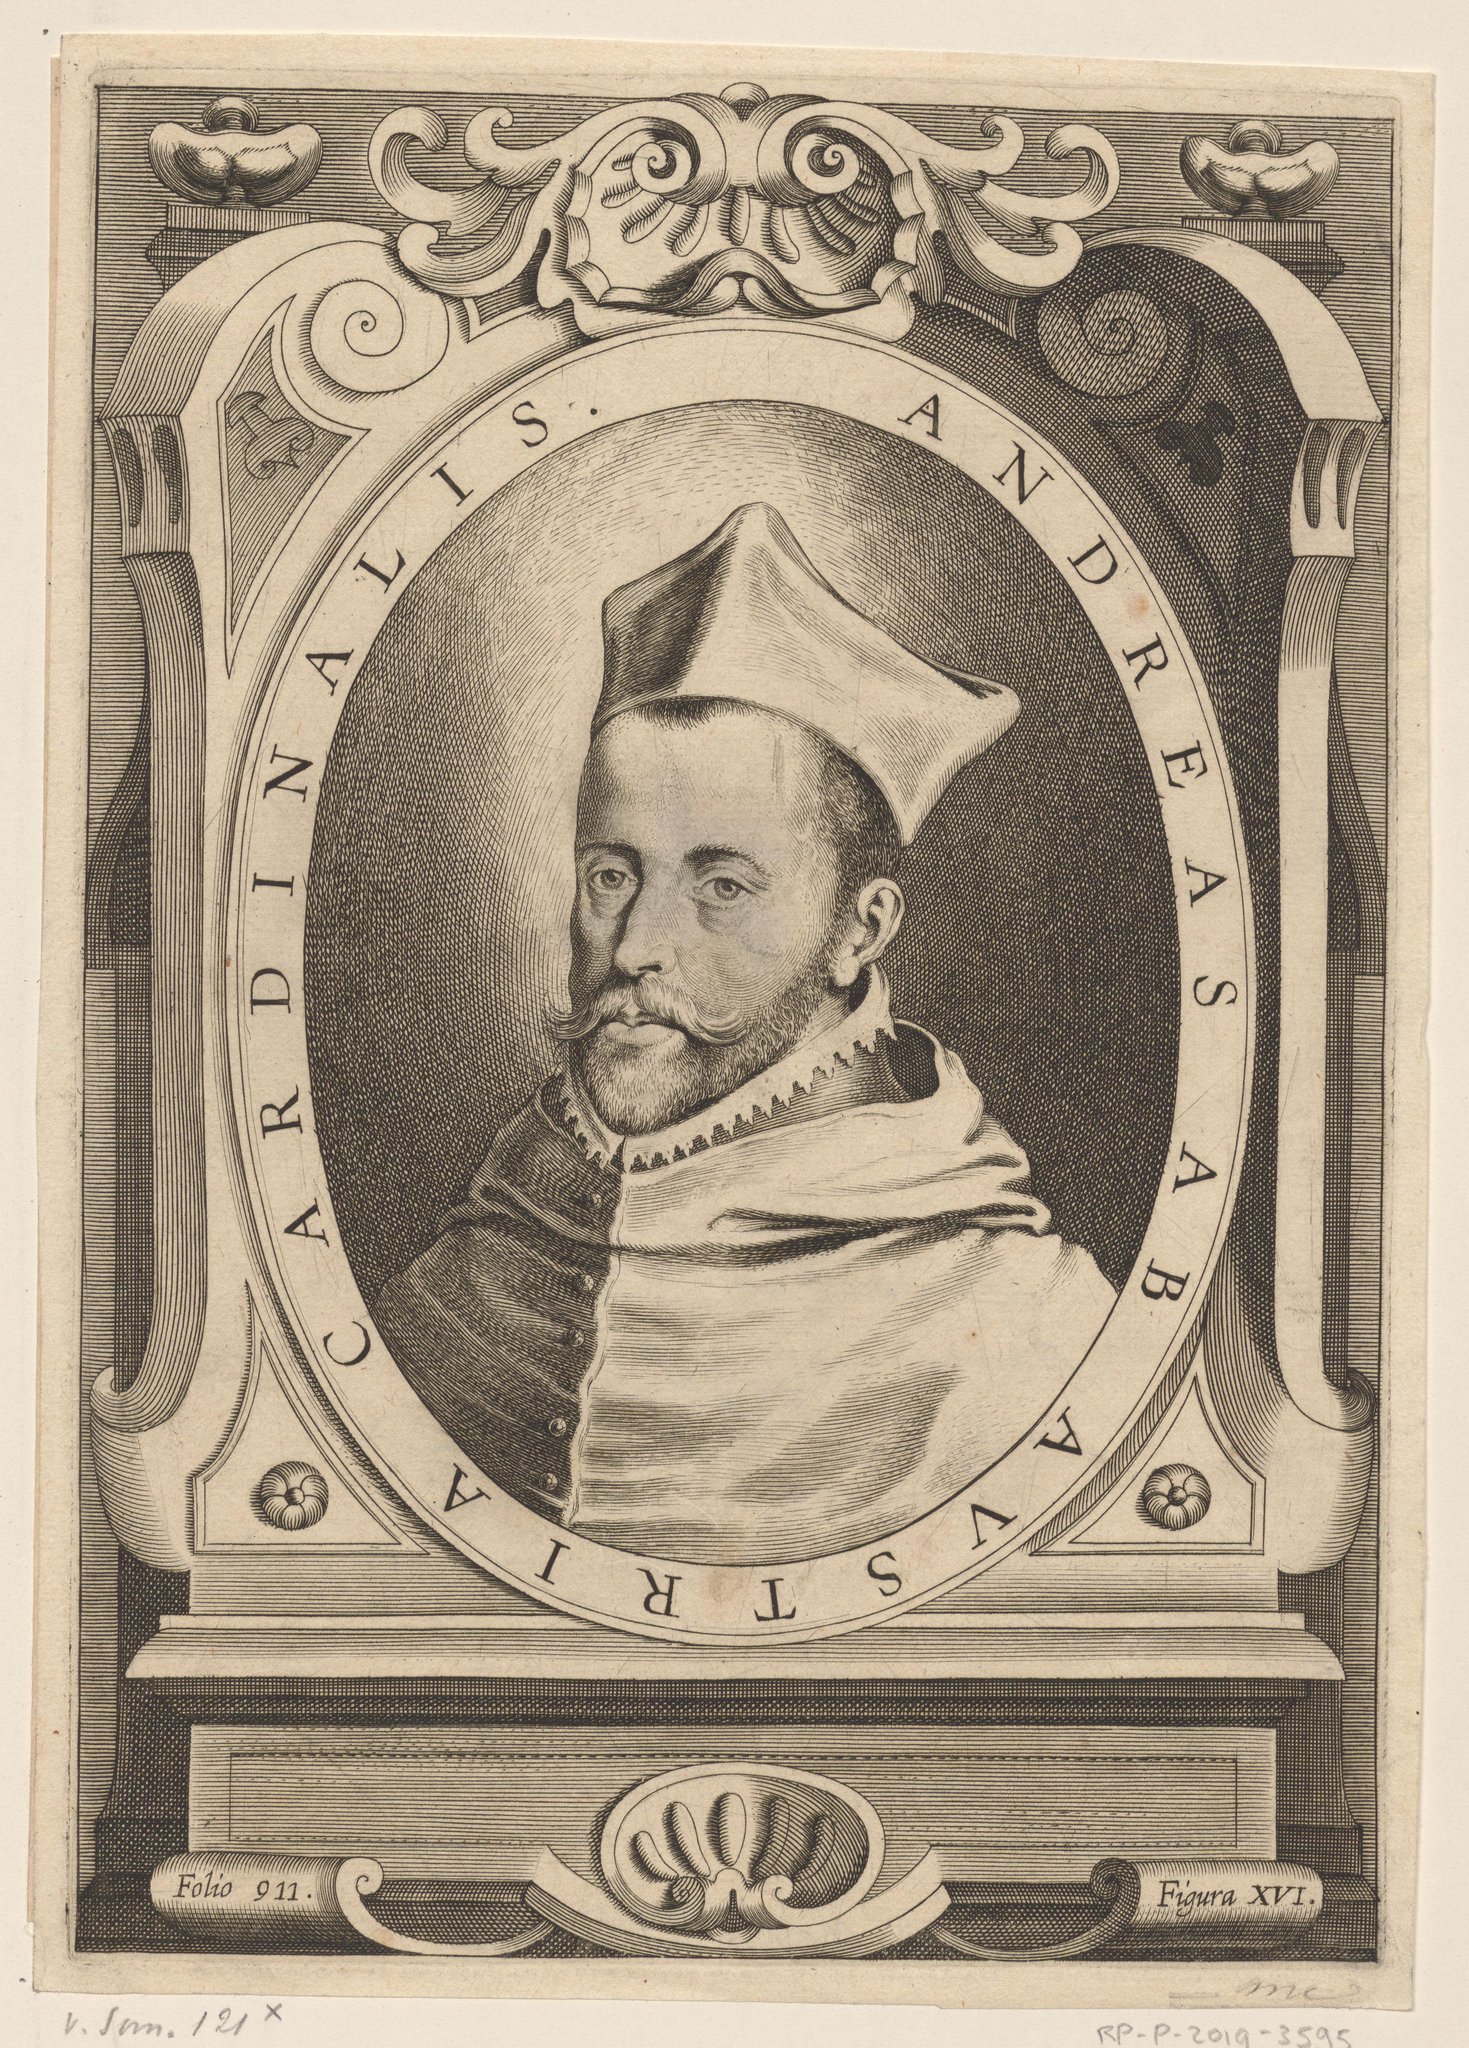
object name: print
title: Portret van Andreas van Oostenrijk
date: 1620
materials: paper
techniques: engraving, etching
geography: antwerp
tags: historical persons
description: Prent uit: Meerbeeck, Adriaen van. Chroniike vande gantsche werelt, en sonderlinghe vande seventhien Nederlanden (...). Antwerpen: Hieronymus Verdussen, 1620, p. 911.